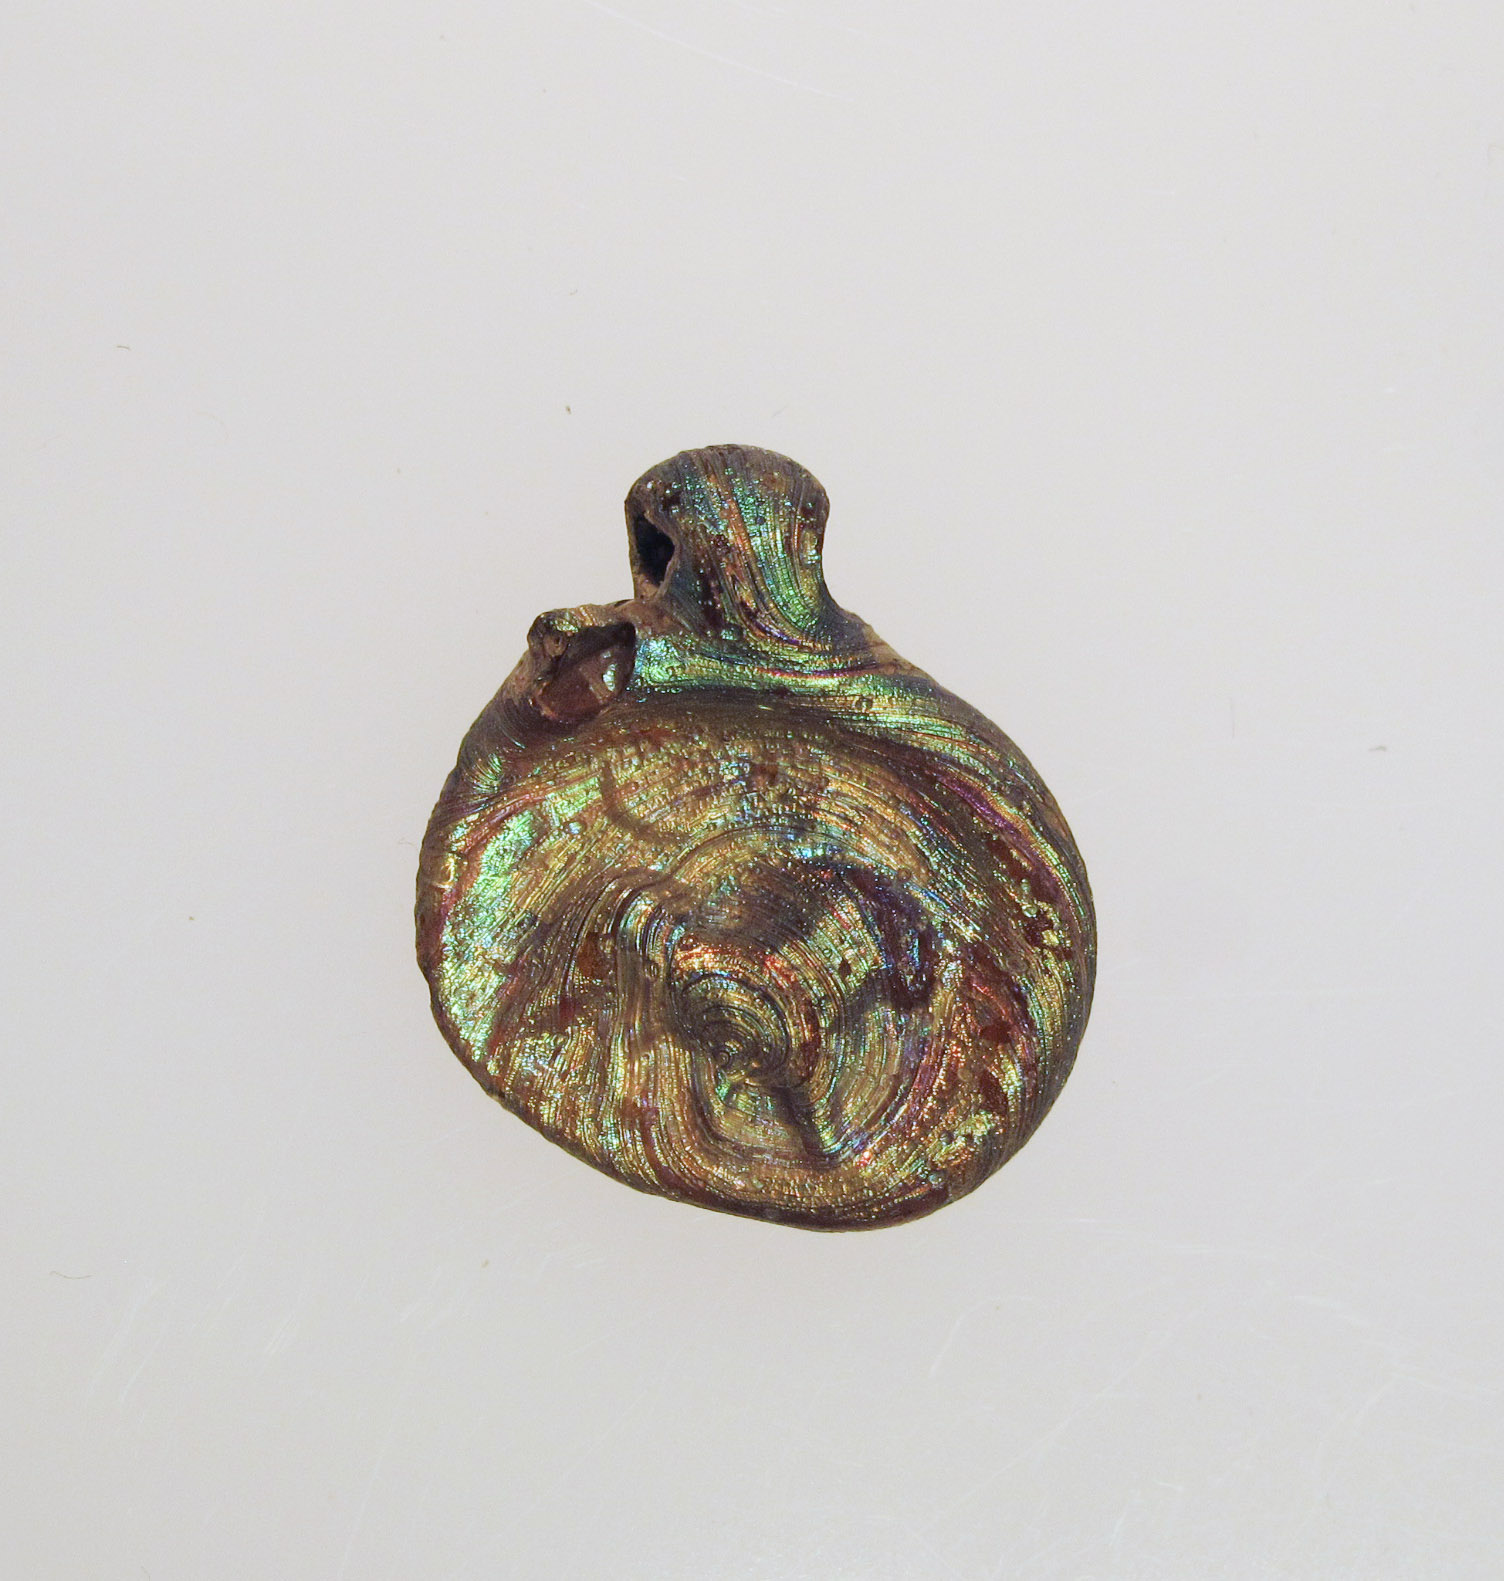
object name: pendant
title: Glass pendant with lion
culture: roman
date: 301-500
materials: glass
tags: lions